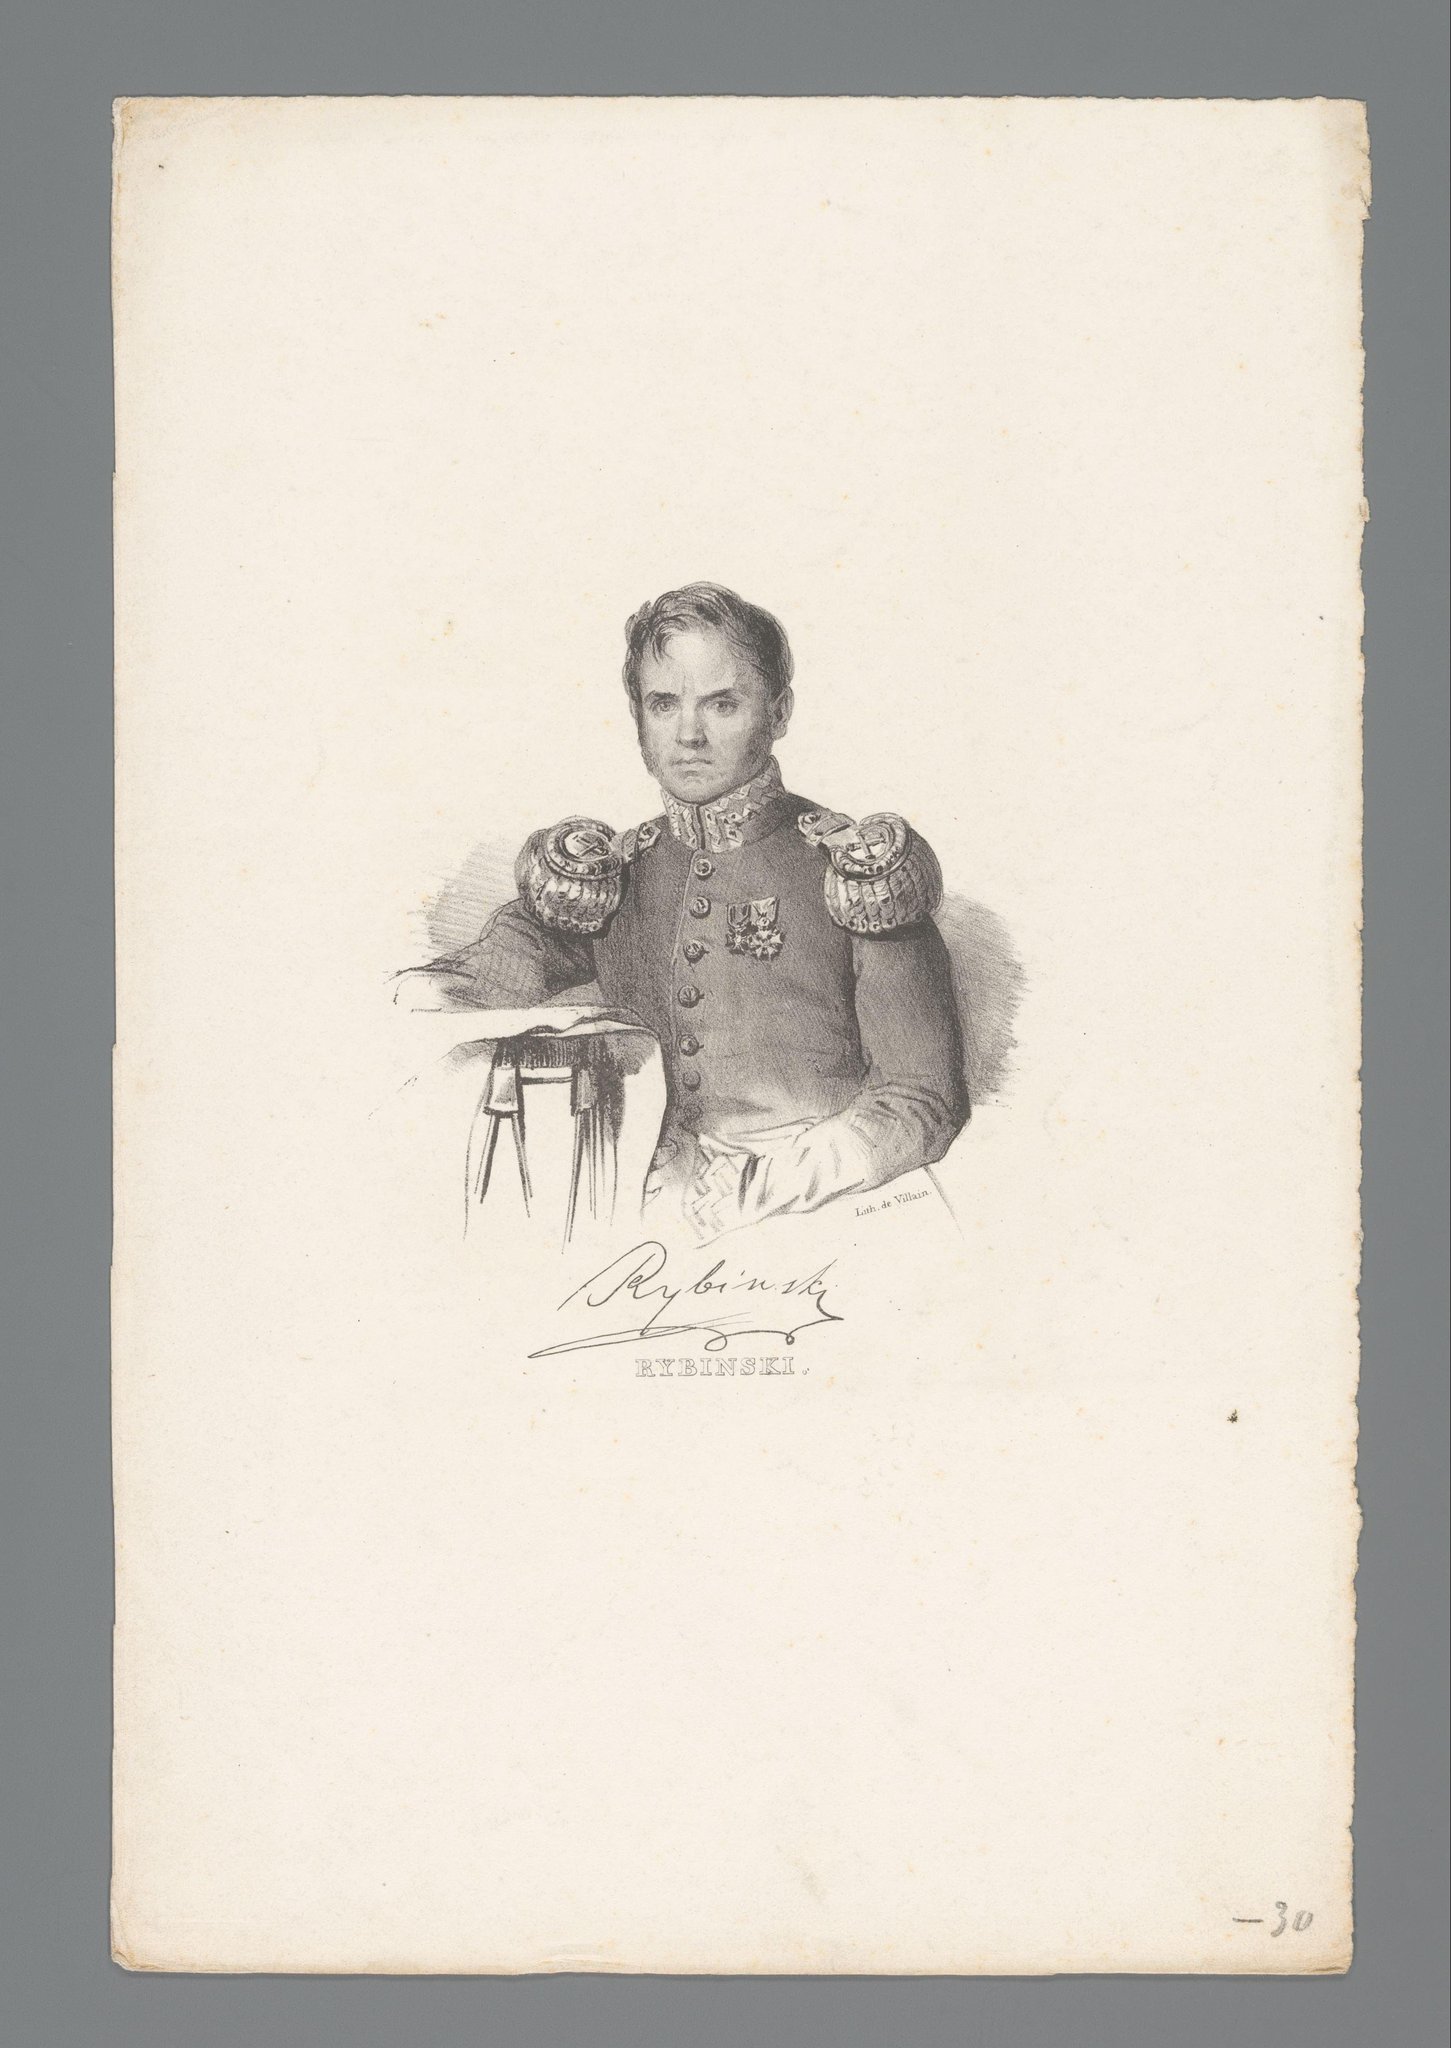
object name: print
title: Rybinski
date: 1832-1839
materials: paper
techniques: lithograph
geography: paris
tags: paris, historical persons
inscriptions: collector's mark: Lugt 2228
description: Prent uit: Straszewicz., Joseph. Les polonais et les polonaises de la révolution du 29 novembre 1830, ou Portraits des personnes qui ont figuré dans la dernière guerre de l'indépendance polonaise, avec les fac-simile de leur signature, lithographiés sur dessins originaux, par les artistes les plus distingués: MM. Grévedon, Maurin, Vigneron, Belliard, Devéria, Bazin, Desmadryl, Lecler, Desmaisons, Rutowski, officier polonais, etc,. etc., accompagnés d'une biographie pour chaque portrait. Parijs: Catherine-Anaïs Pinard, 1832. Of uit: Straszewicz., Joseph. Les polonais et les polonaises de la révolution du 29 novembre 1830. Biographie des personnes qui ont figuré dans la dernière guerre de l'indépendance polonaise, avec les fac-simile de leur signature, ornée de 30 portraits lithographiés sur dessins originaux, par les artistes les plus distingués: MM. Grévedon, Maurin, Vigneron, Belliard, Devéria, Bazin, Desmadryl, Lecler, etc., etc.. Parijs: s.n., 1839.